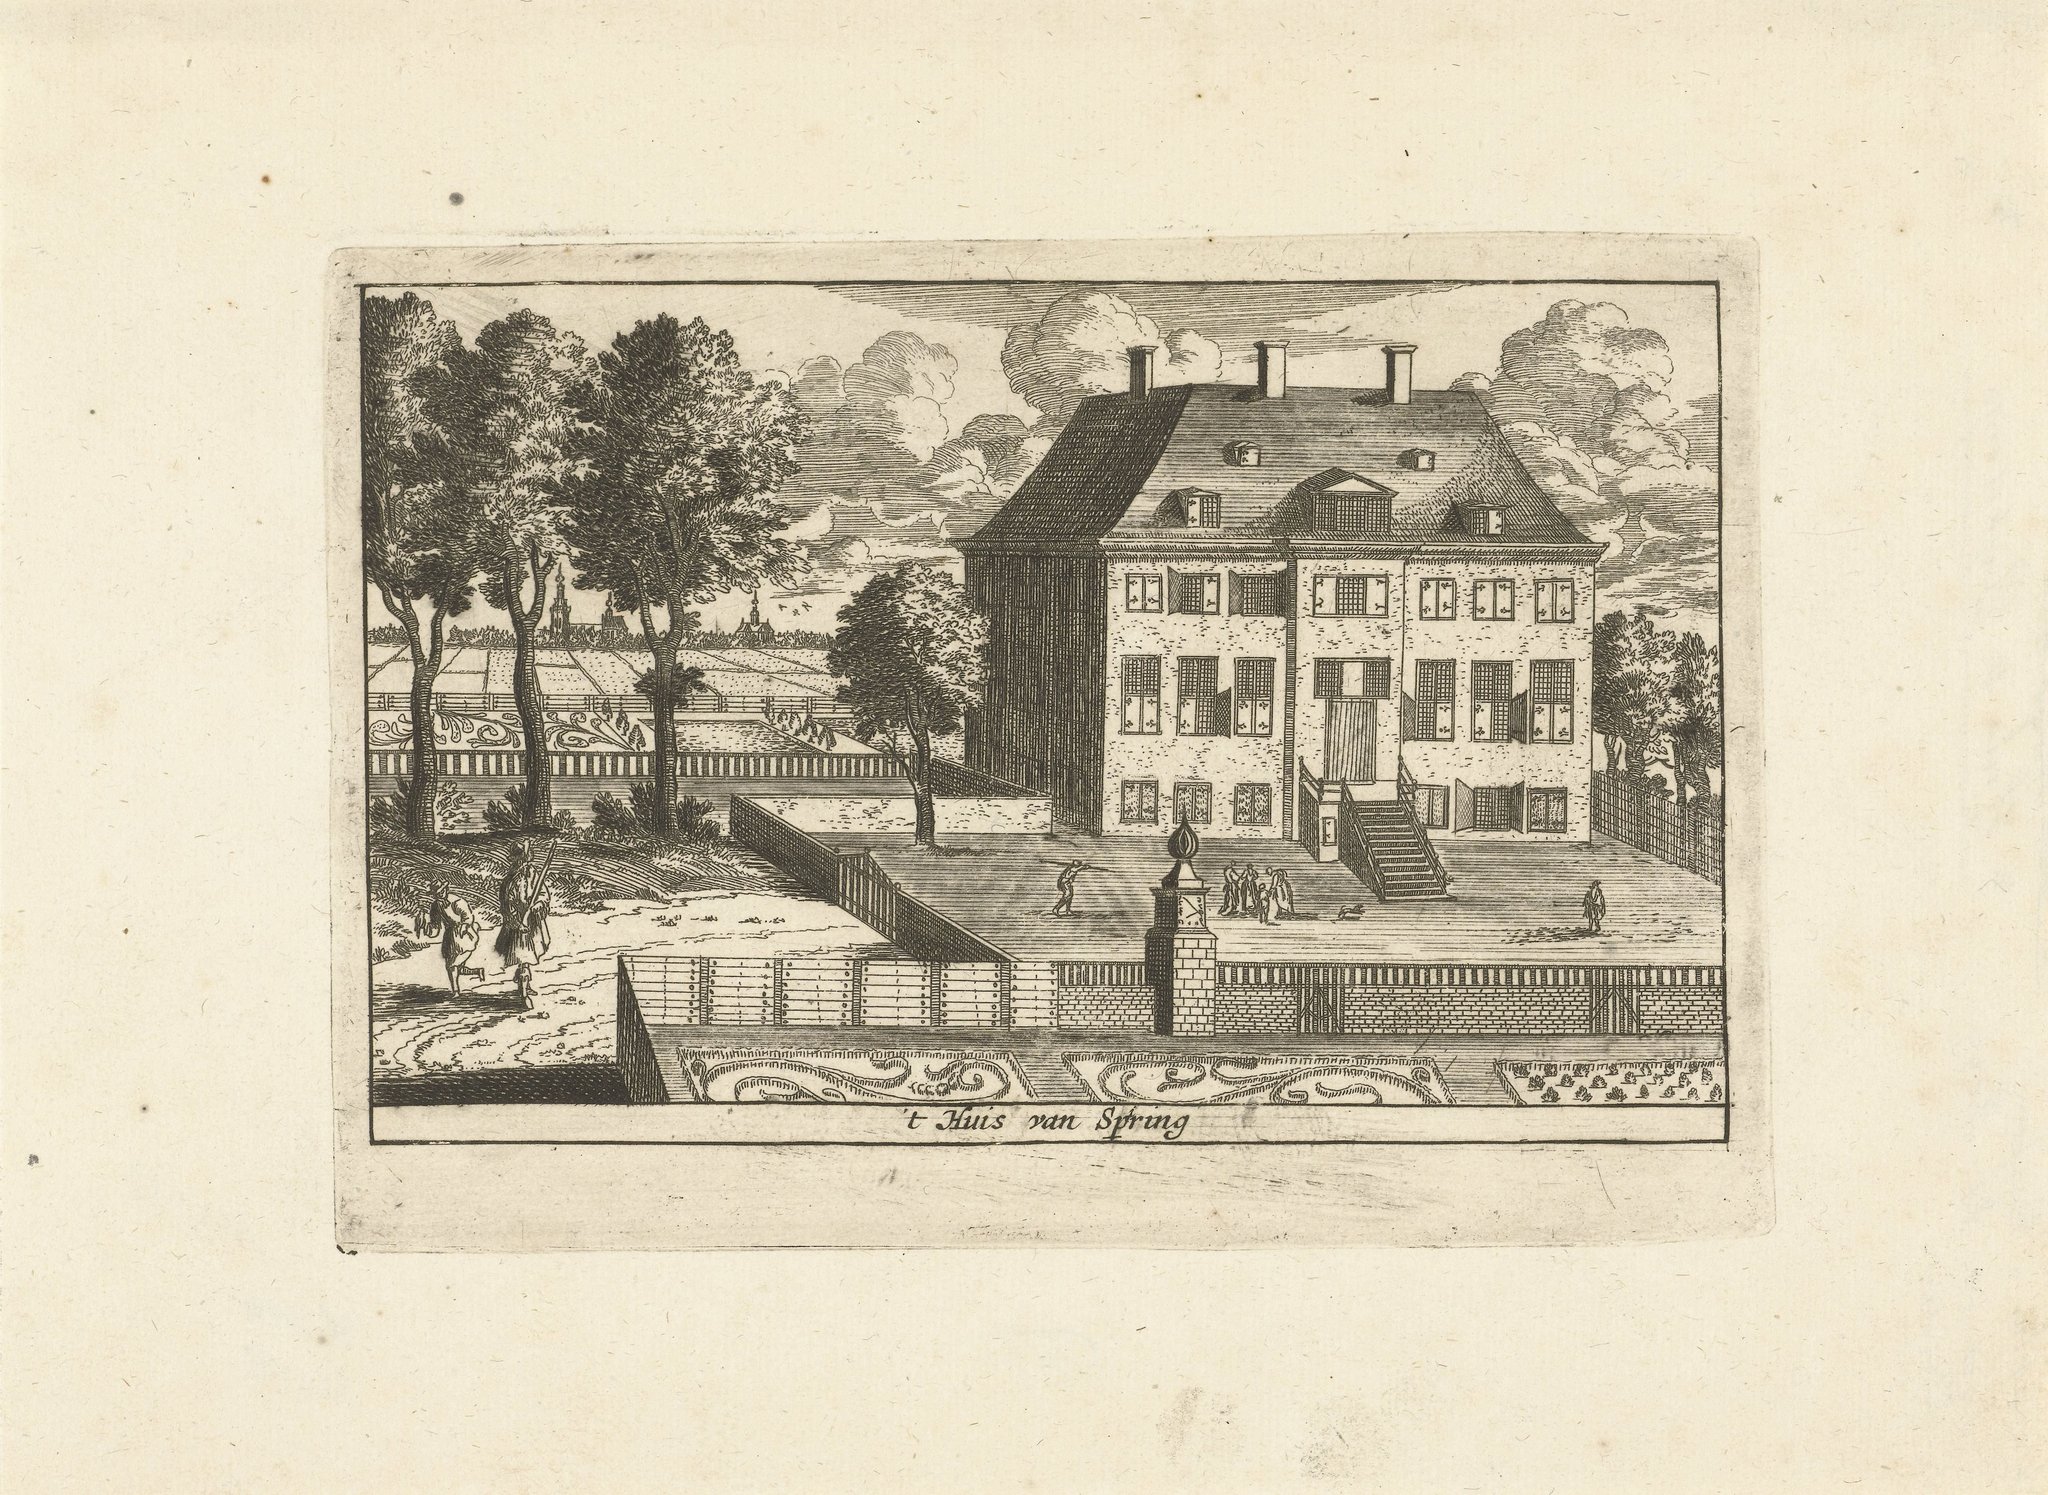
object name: print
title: Landhuis met valkenier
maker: cornelis elandts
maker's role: draughtsman, painter, print maker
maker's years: 1641-1687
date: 1663-1670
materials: paper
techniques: etching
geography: the hague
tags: rural housing, e.g. country-house, villa, cottage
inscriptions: collector's mark: Lugt 2228, inscription: ‘...Atlas van Rijnland / is legaat van Ch. Dozy / te Leiden’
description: Een landhuis met tuin waarin verschillende mensen en een hond zijn afgebeeld. Op de voorgrond is een deel van een spiegelsymmetrische tuin zichtbaar en op de stenen zuil van het hek een zonnenwijzer. Op het pad buiten de tuinen staan een valkenier en een jager.